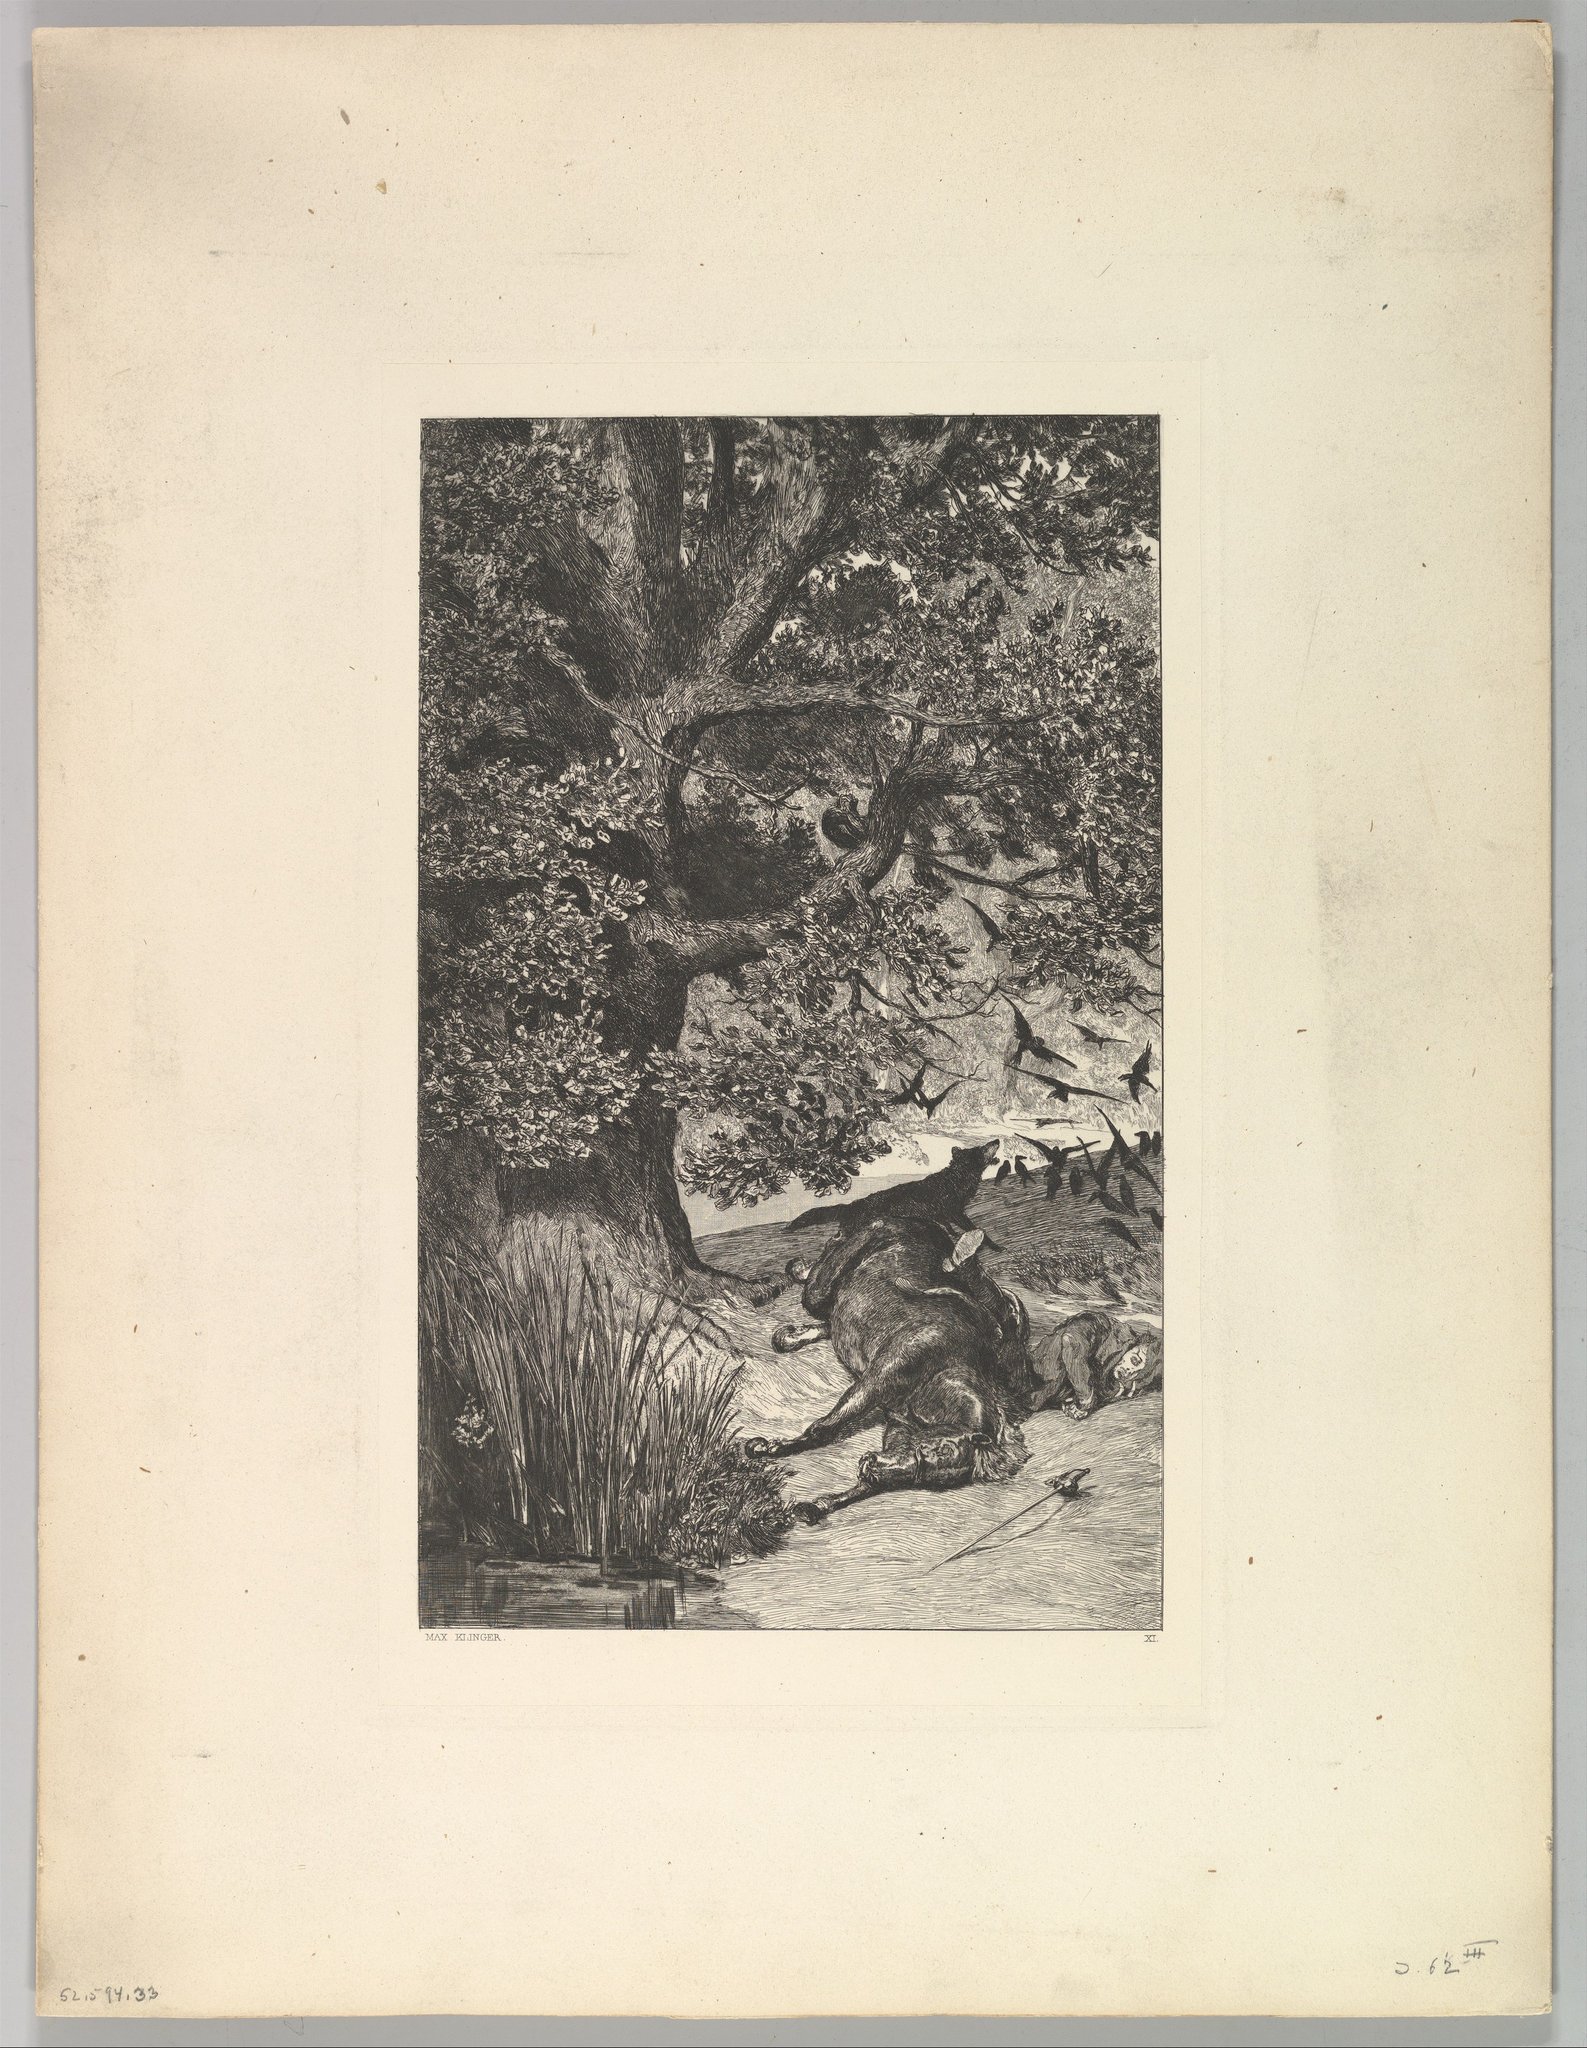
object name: print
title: Gefallener Reiter, from the series Intermezzi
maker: max klinger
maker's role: artist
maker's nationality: german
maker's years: 1857-1920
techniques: aquatint, printmaking, etching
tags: men,horses,trees,death